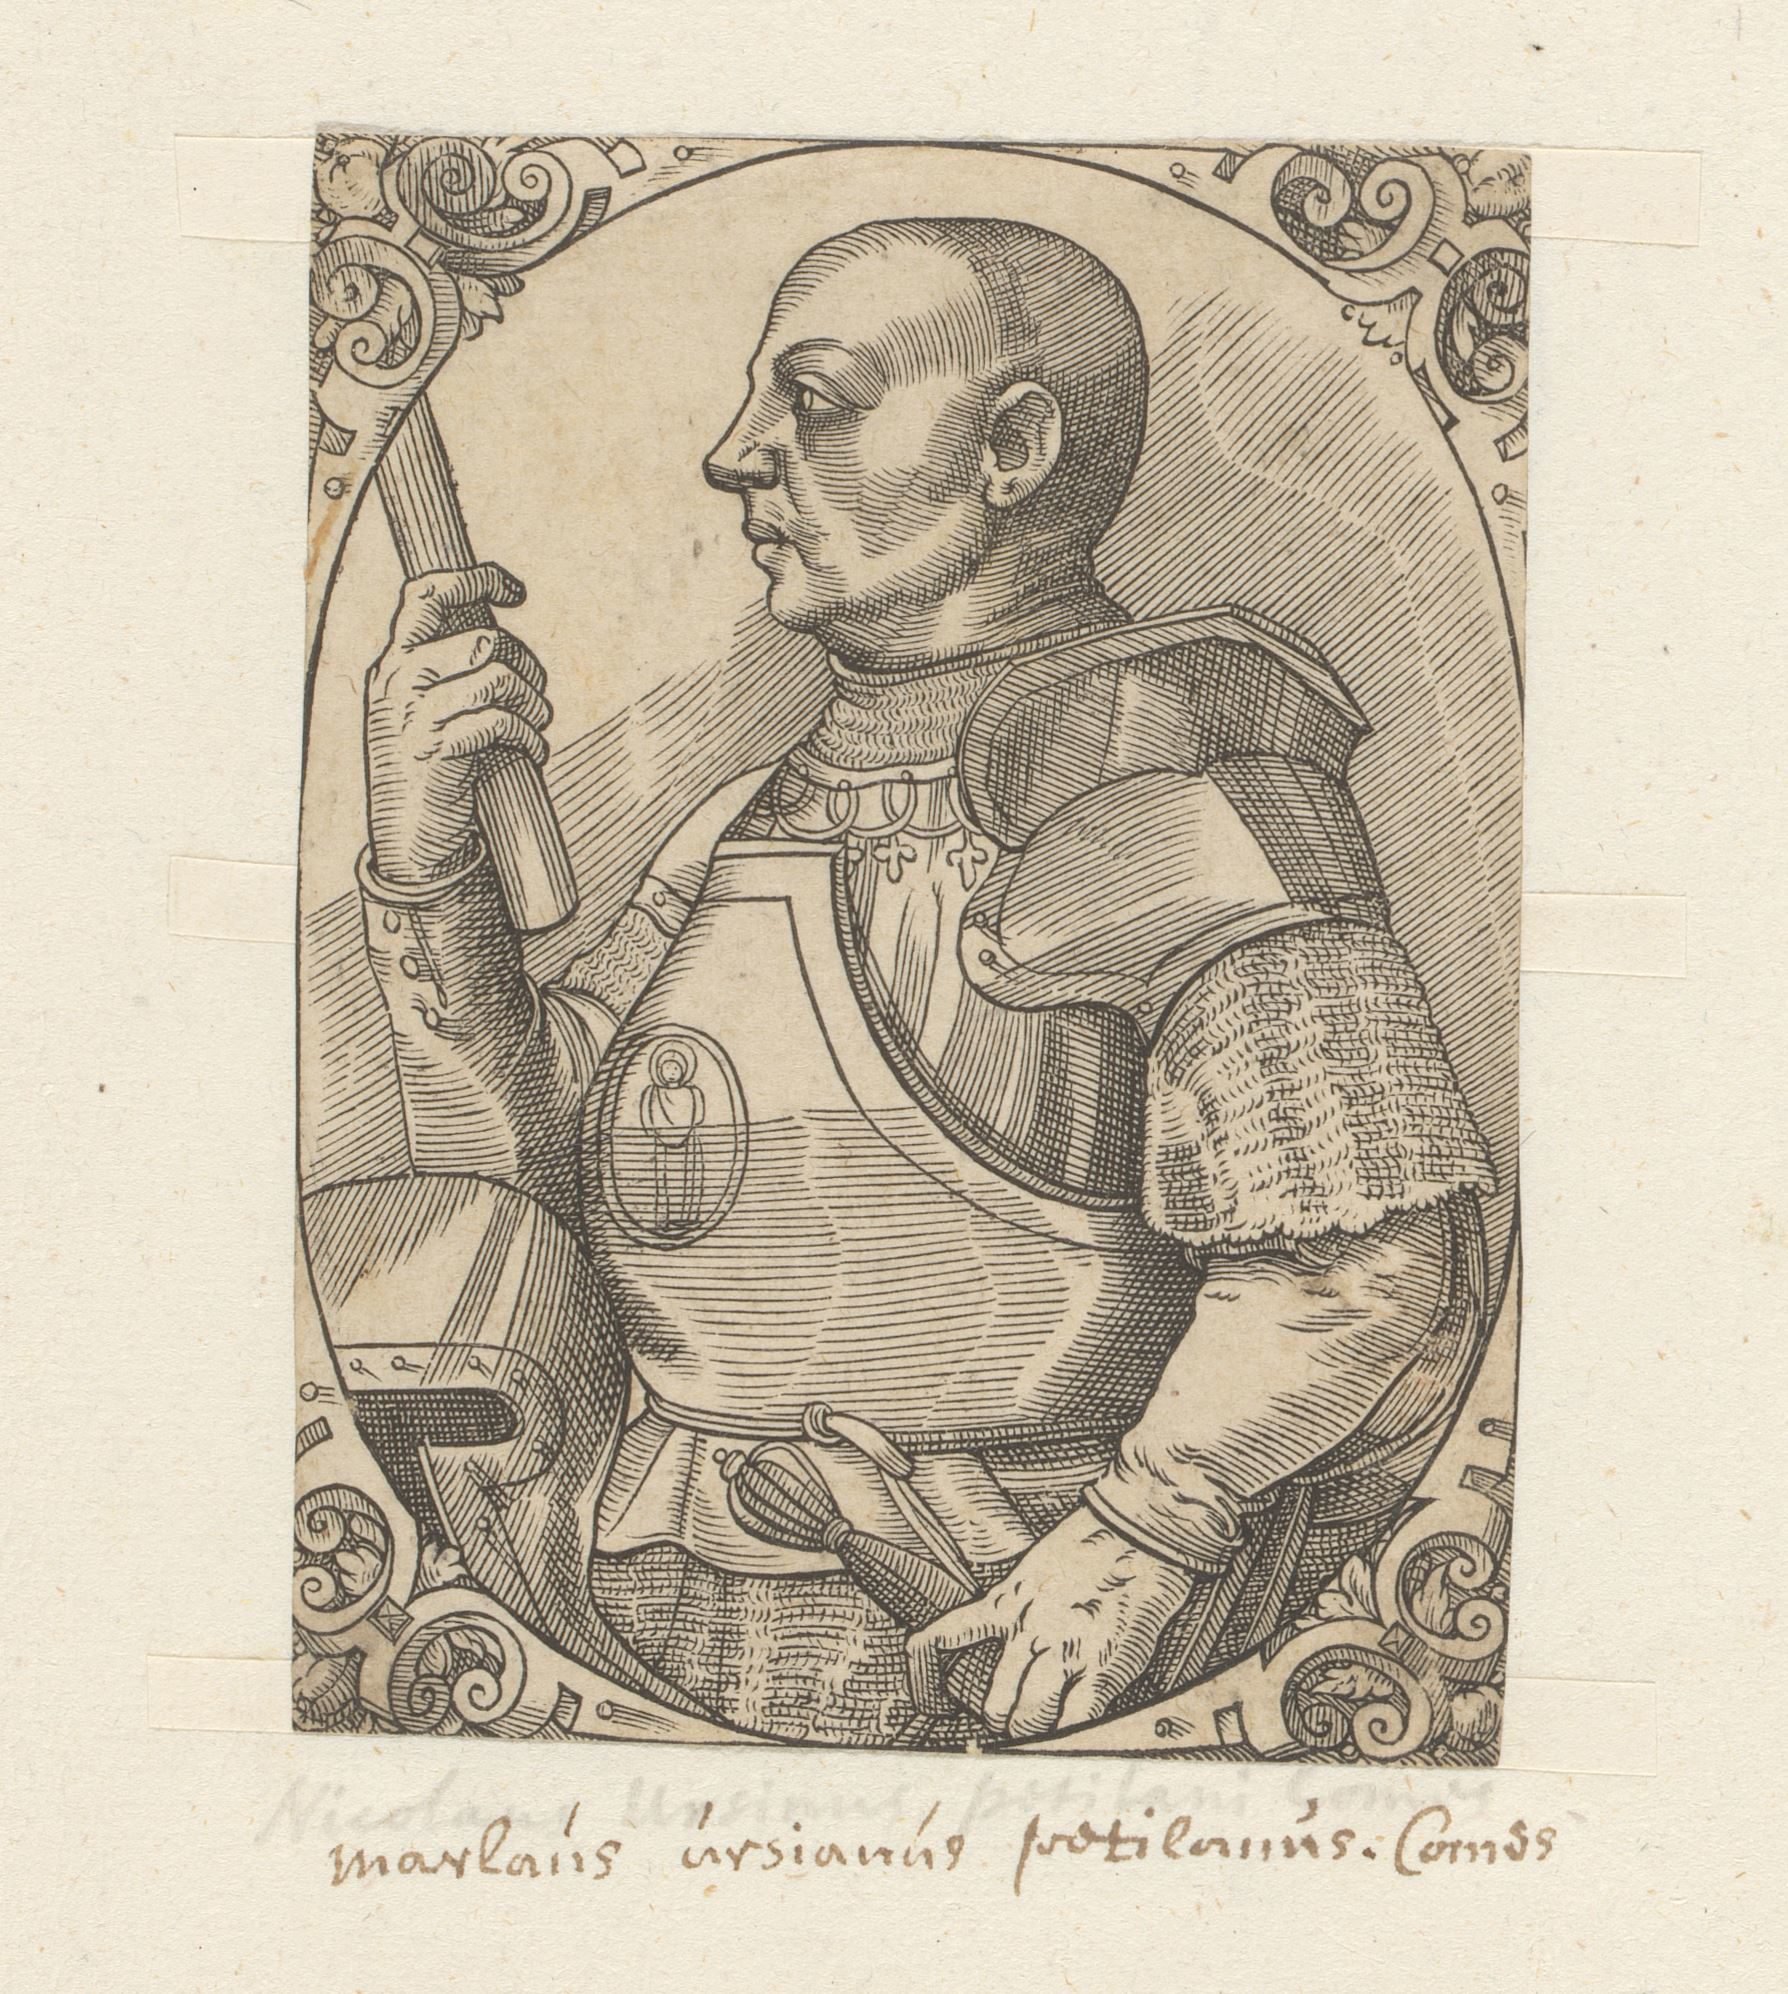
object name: book illustration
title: Portret van Niccolò di Pitigliano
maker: Anonymous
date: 1549-1575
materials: paper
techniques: woodcut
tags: pitigliano, commander-in-chief, general, marshal, historical persons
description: Prent gebruikt in: Giovio, Paolo. Elogia Virorum bellica virtute illustrium (...). Bazel: Peter Perna, 1575.